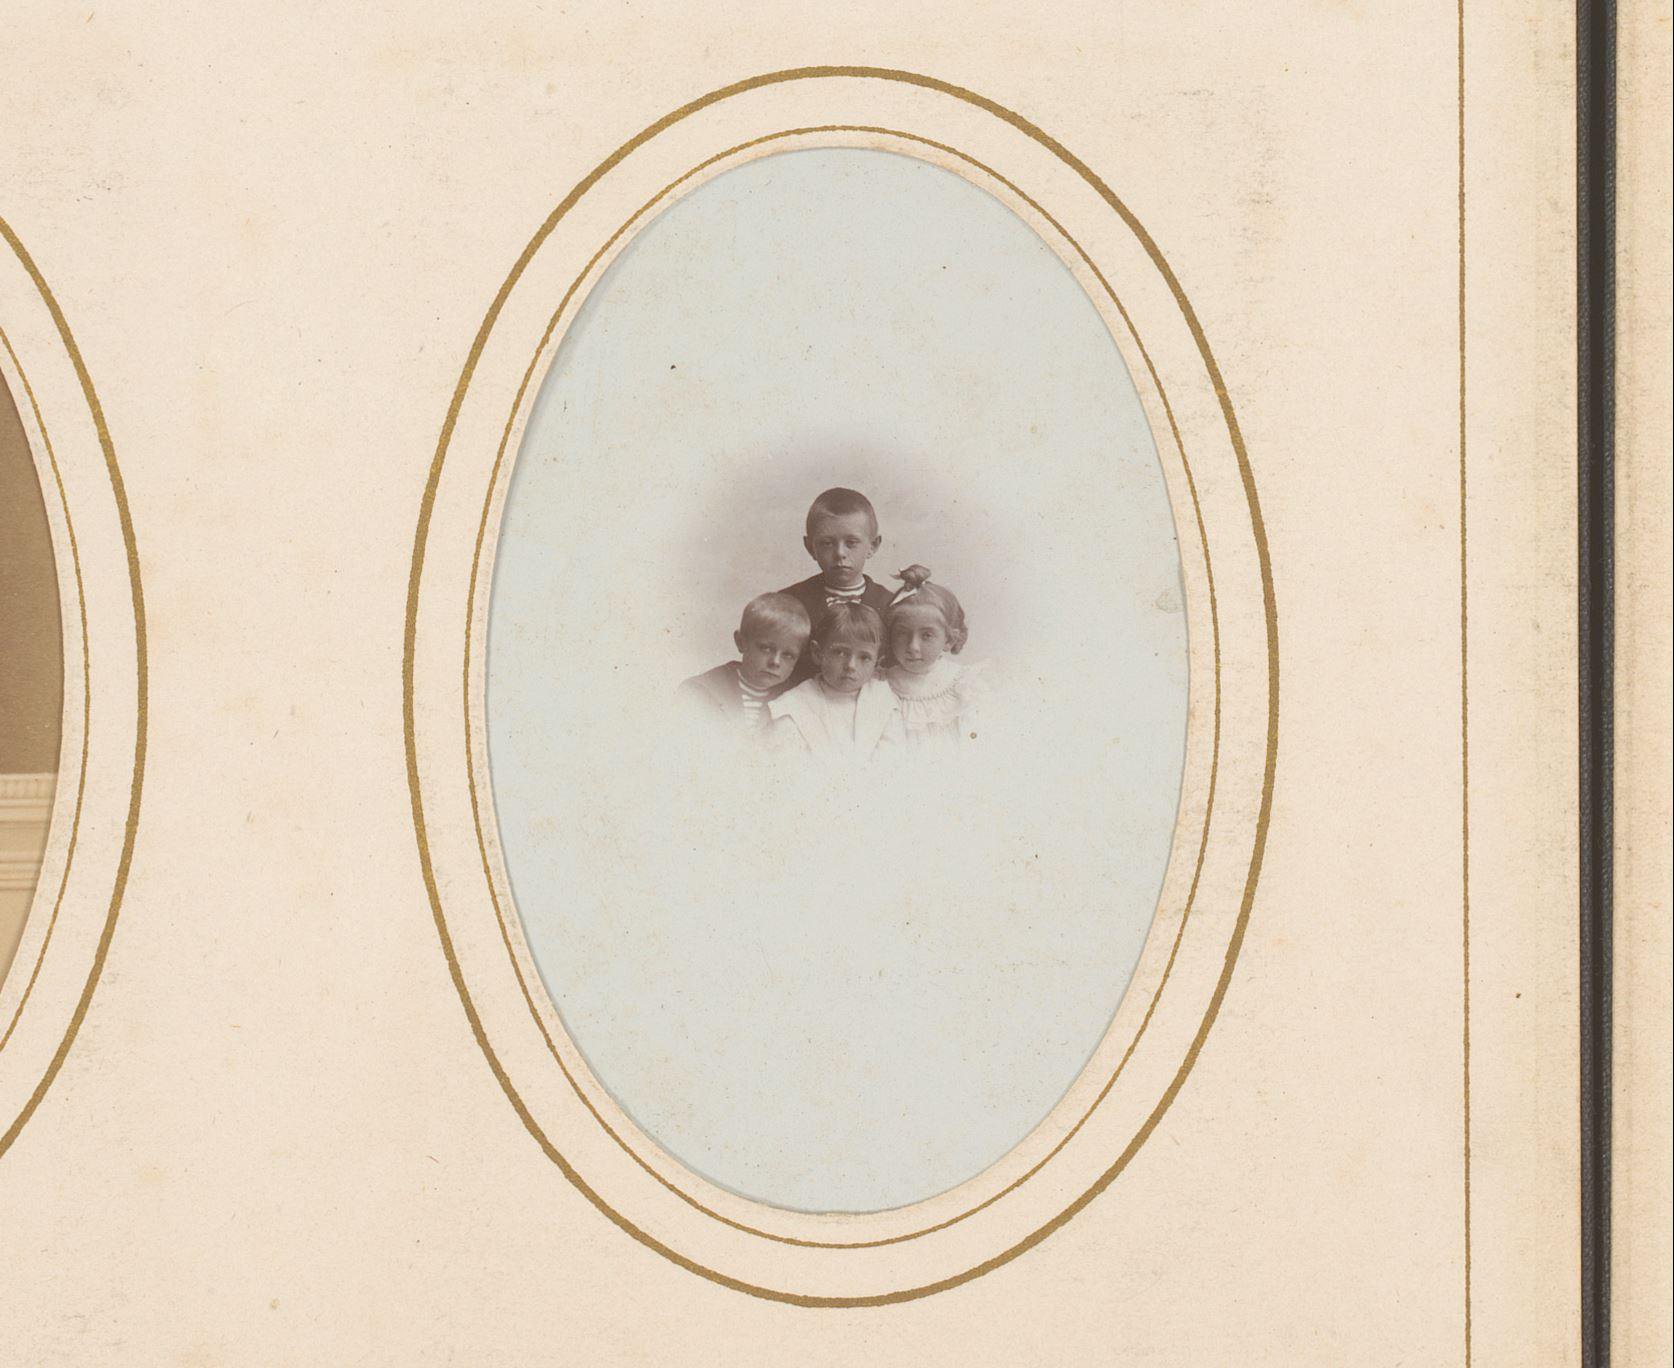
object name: album leaf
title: Portret van vier kinderen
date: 1881-1904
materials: cardboard, photographic support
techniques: collodion silver print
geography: blankenberge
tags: boy (child between toddler and youth) (+ two persons), girl (child between toddler and youth) (+ two persons), anonymous historical persons portrayed in a group, in a group-portrait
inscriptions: inscription: ‘Photo Viennoise Blankenberghe’